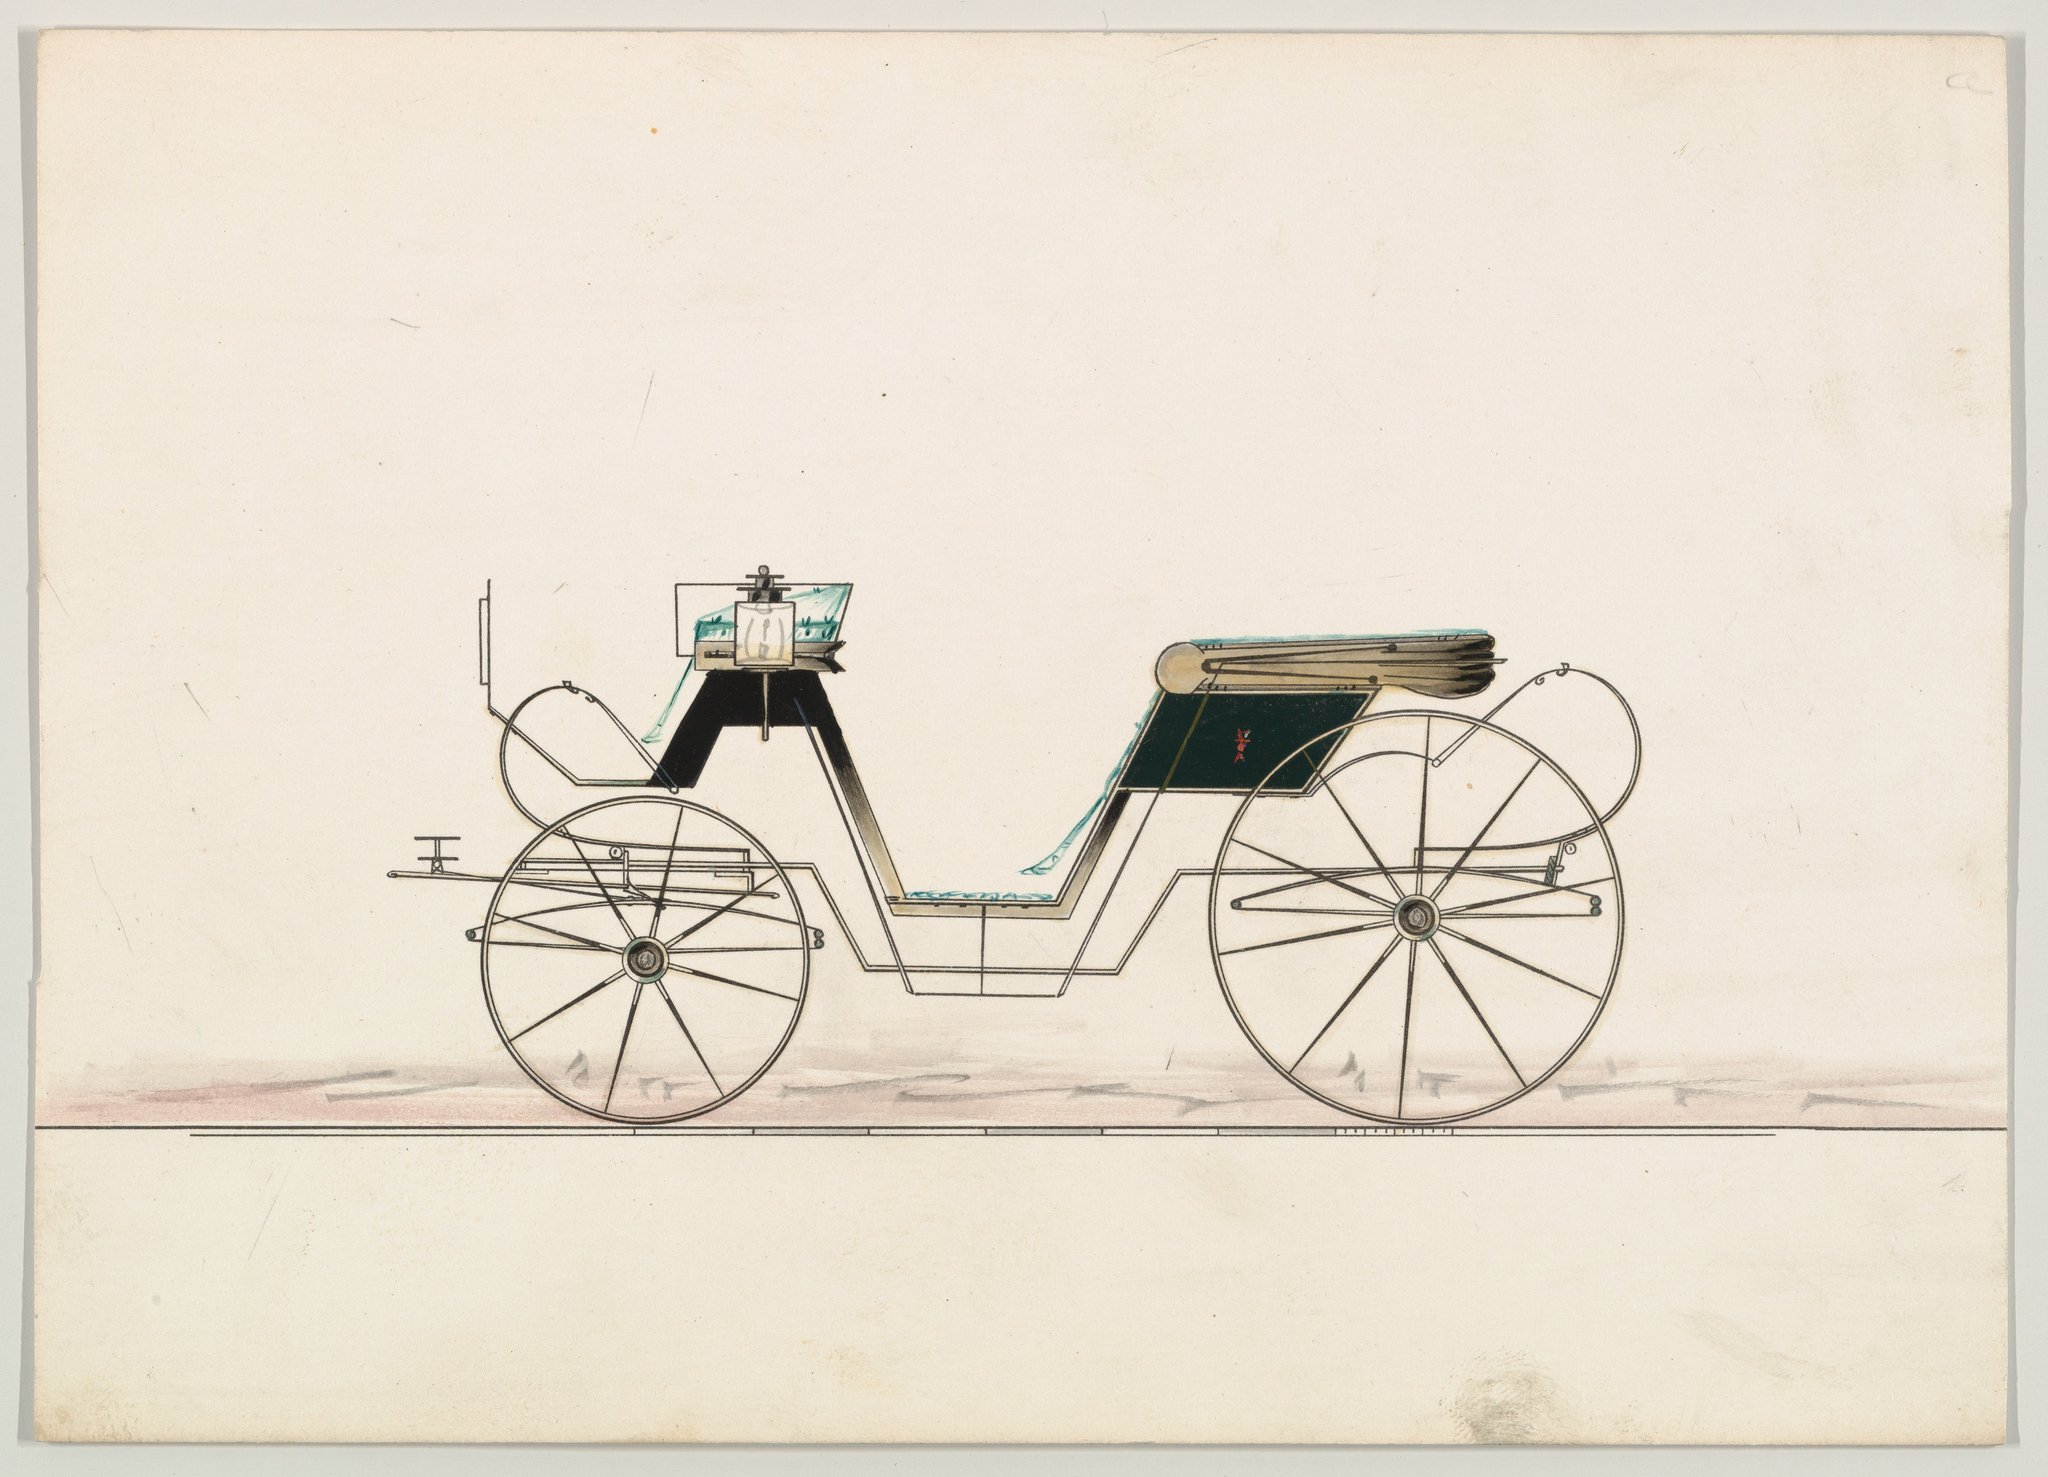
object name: drawing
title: Cabriolet (unnumbered)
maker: brewster & co.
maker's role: manufacturer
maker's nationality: american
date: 1870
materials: gouache, graphite, gum arabic, ink, watercolor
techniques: pen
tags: carriages